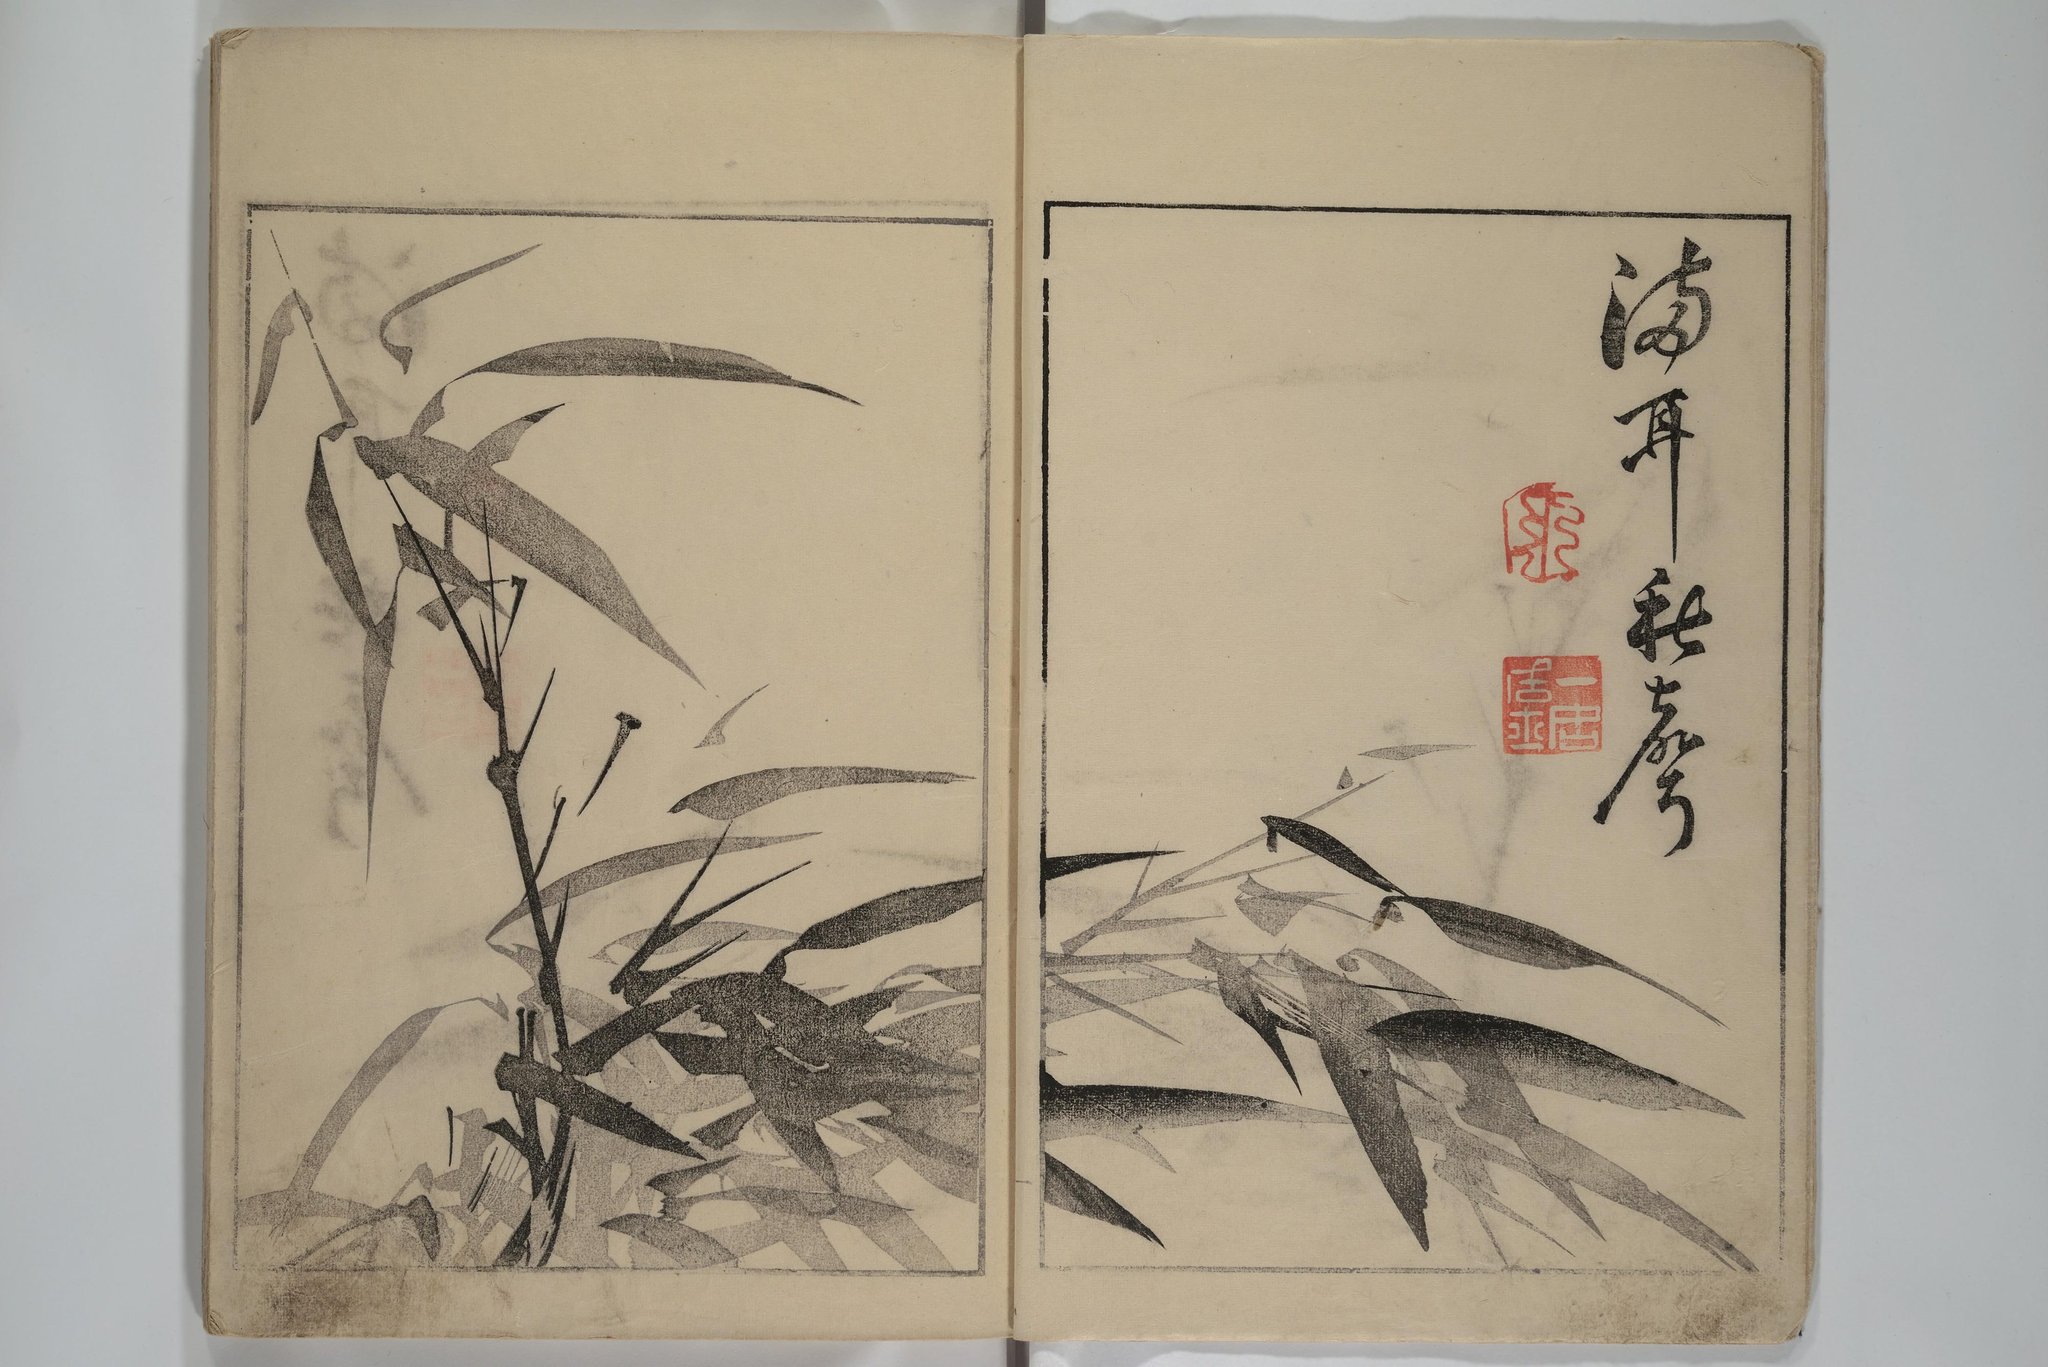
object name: illustrated book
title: Shazanrō (Bunchō) Picture Book (Shazanrō ehon 寫山樓畫本)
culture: japanese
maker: tani bunchō 谷文晁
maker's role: artist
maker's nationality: japanese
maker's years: 1763-1840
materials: ink, paper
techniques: woodblock print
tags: bamboo